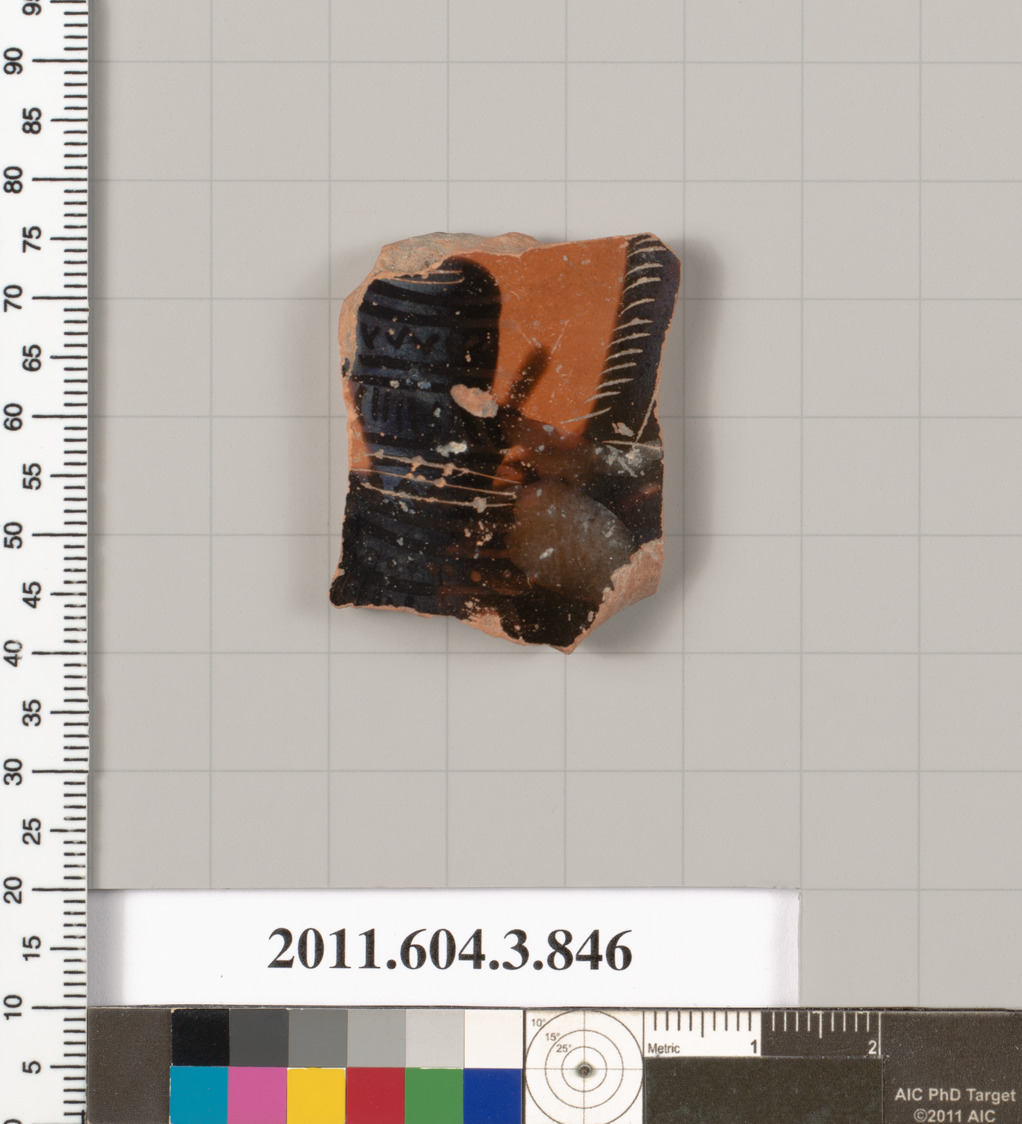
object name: lekythos fragment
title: Terracotta fragment of a lekythos (oil flask)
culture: greek, attic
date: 475-451 BCE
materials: terracotta